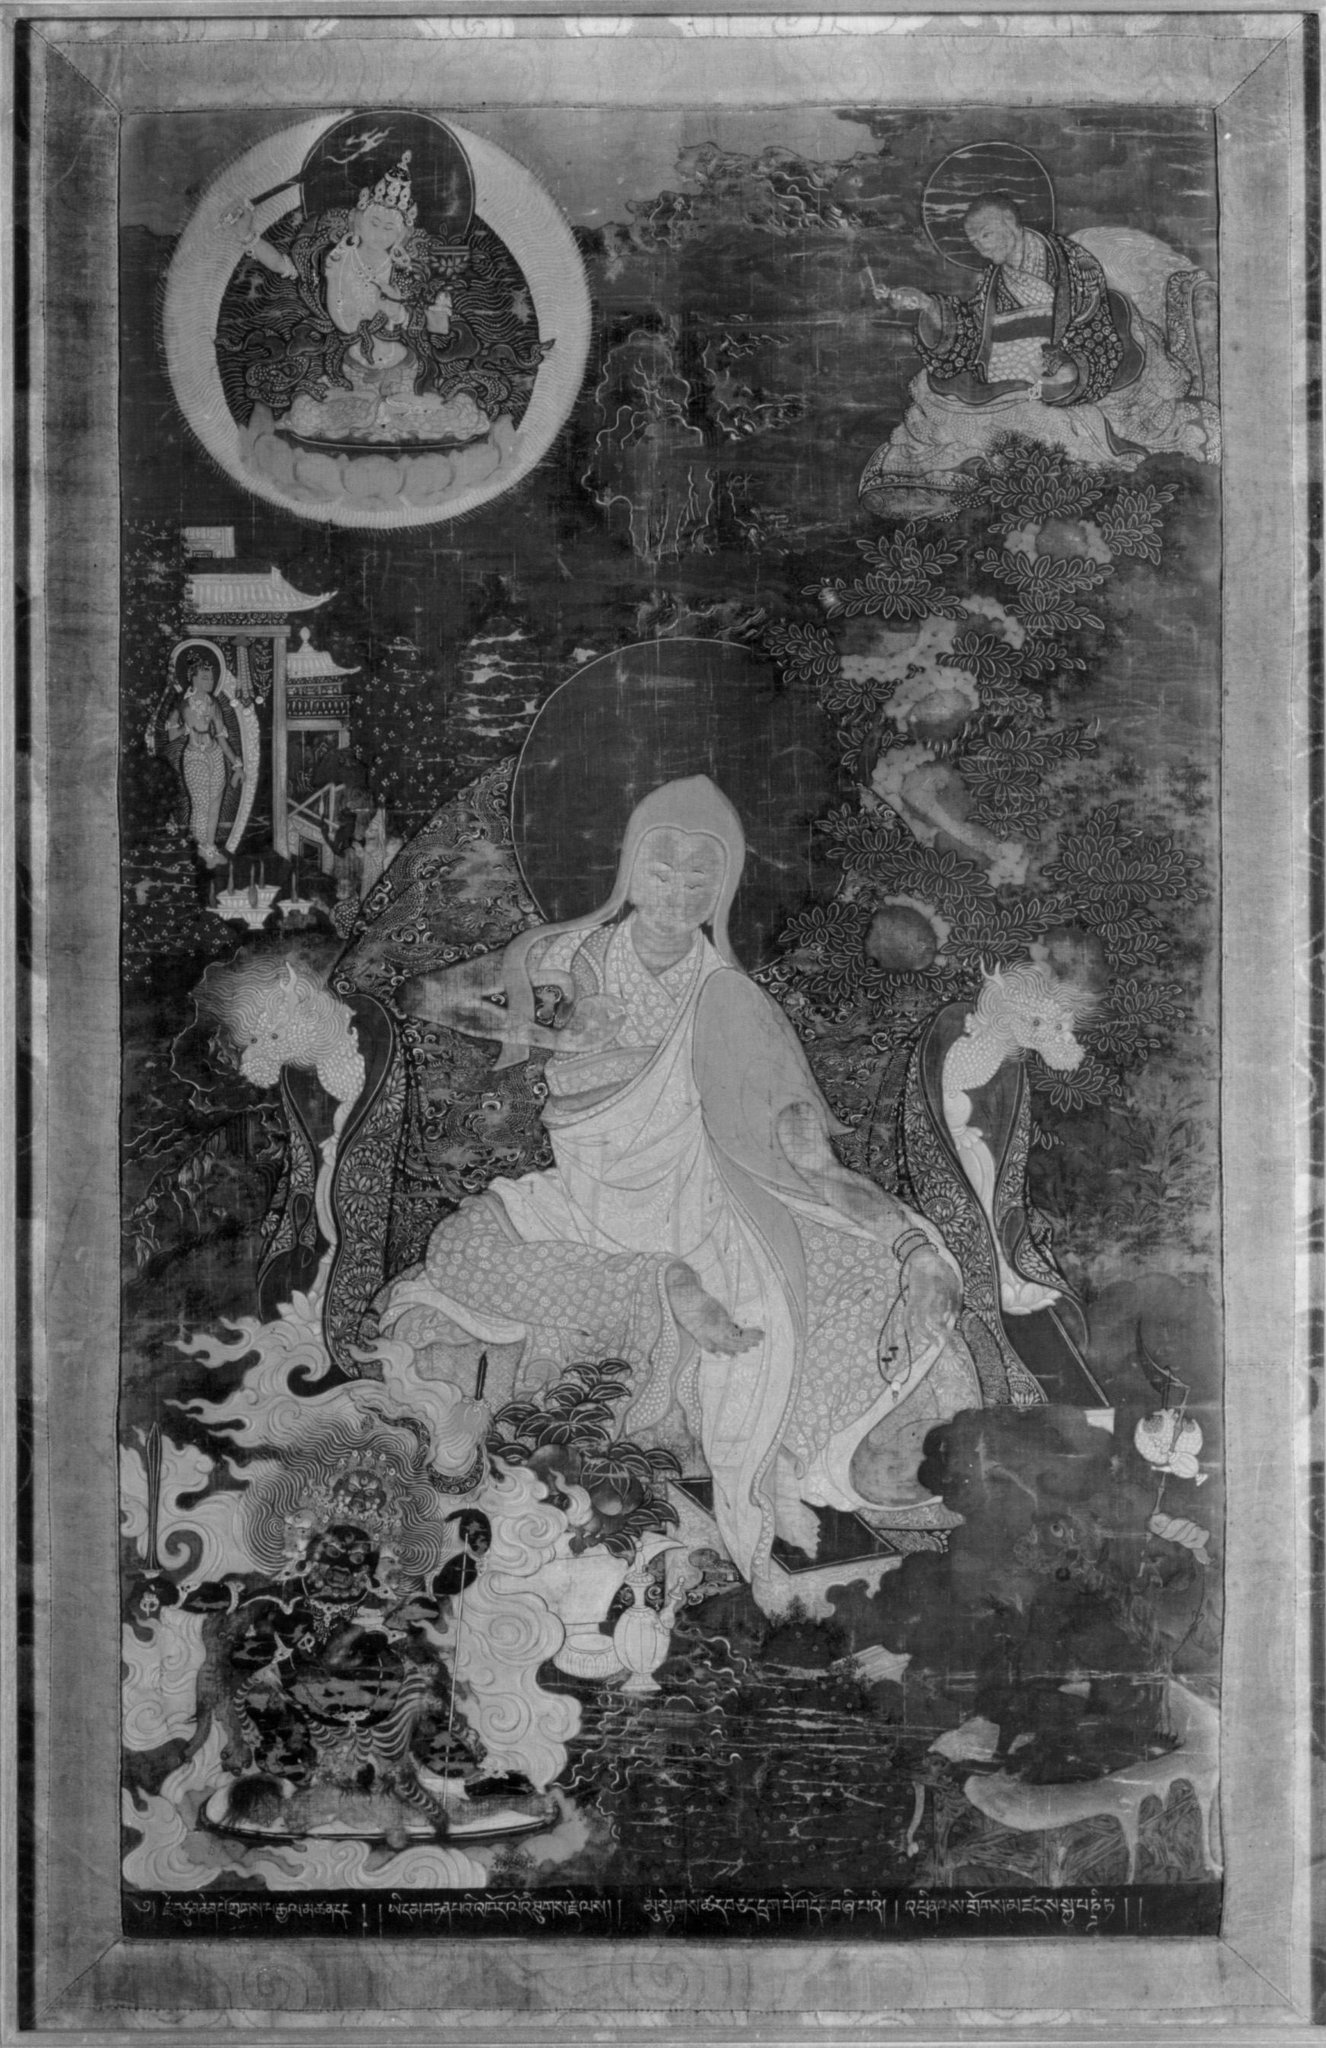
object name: thangka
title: Sakya Pandita (1182–1242)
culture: tibetan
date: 1667-1733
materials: textile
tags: men,buddhism